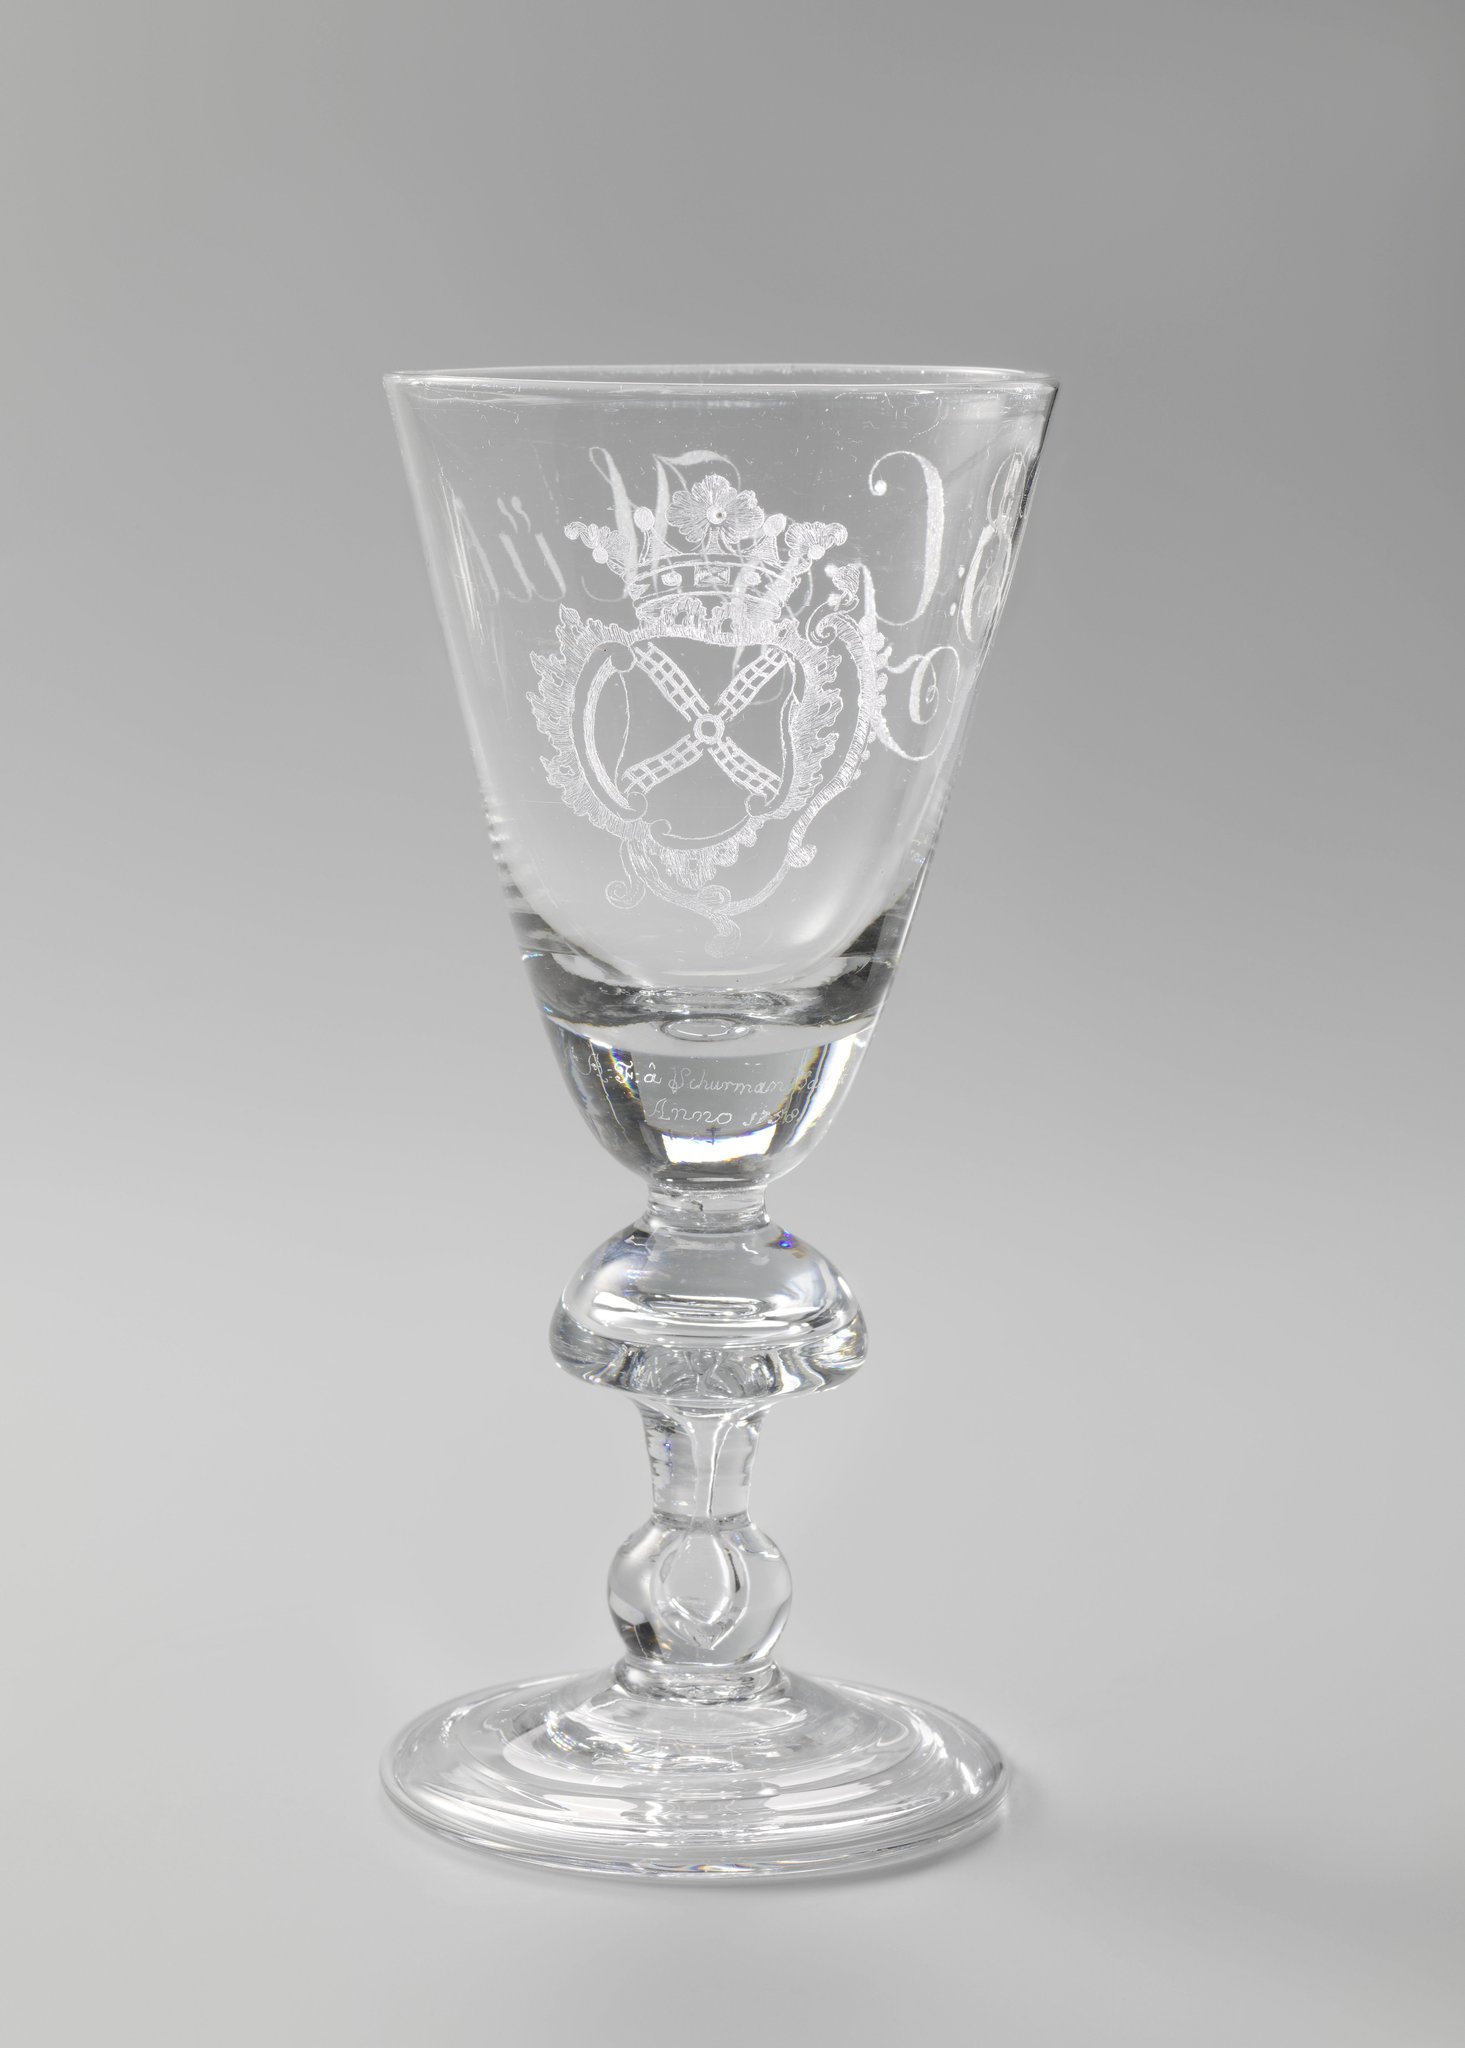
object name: goblet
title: Wine glass with a coat of arms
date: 1758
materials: glass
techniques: diamond point engraving, glassblowing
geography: northern netherlands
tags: armorial bearing, heraldry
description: inscription: B.G. Müller